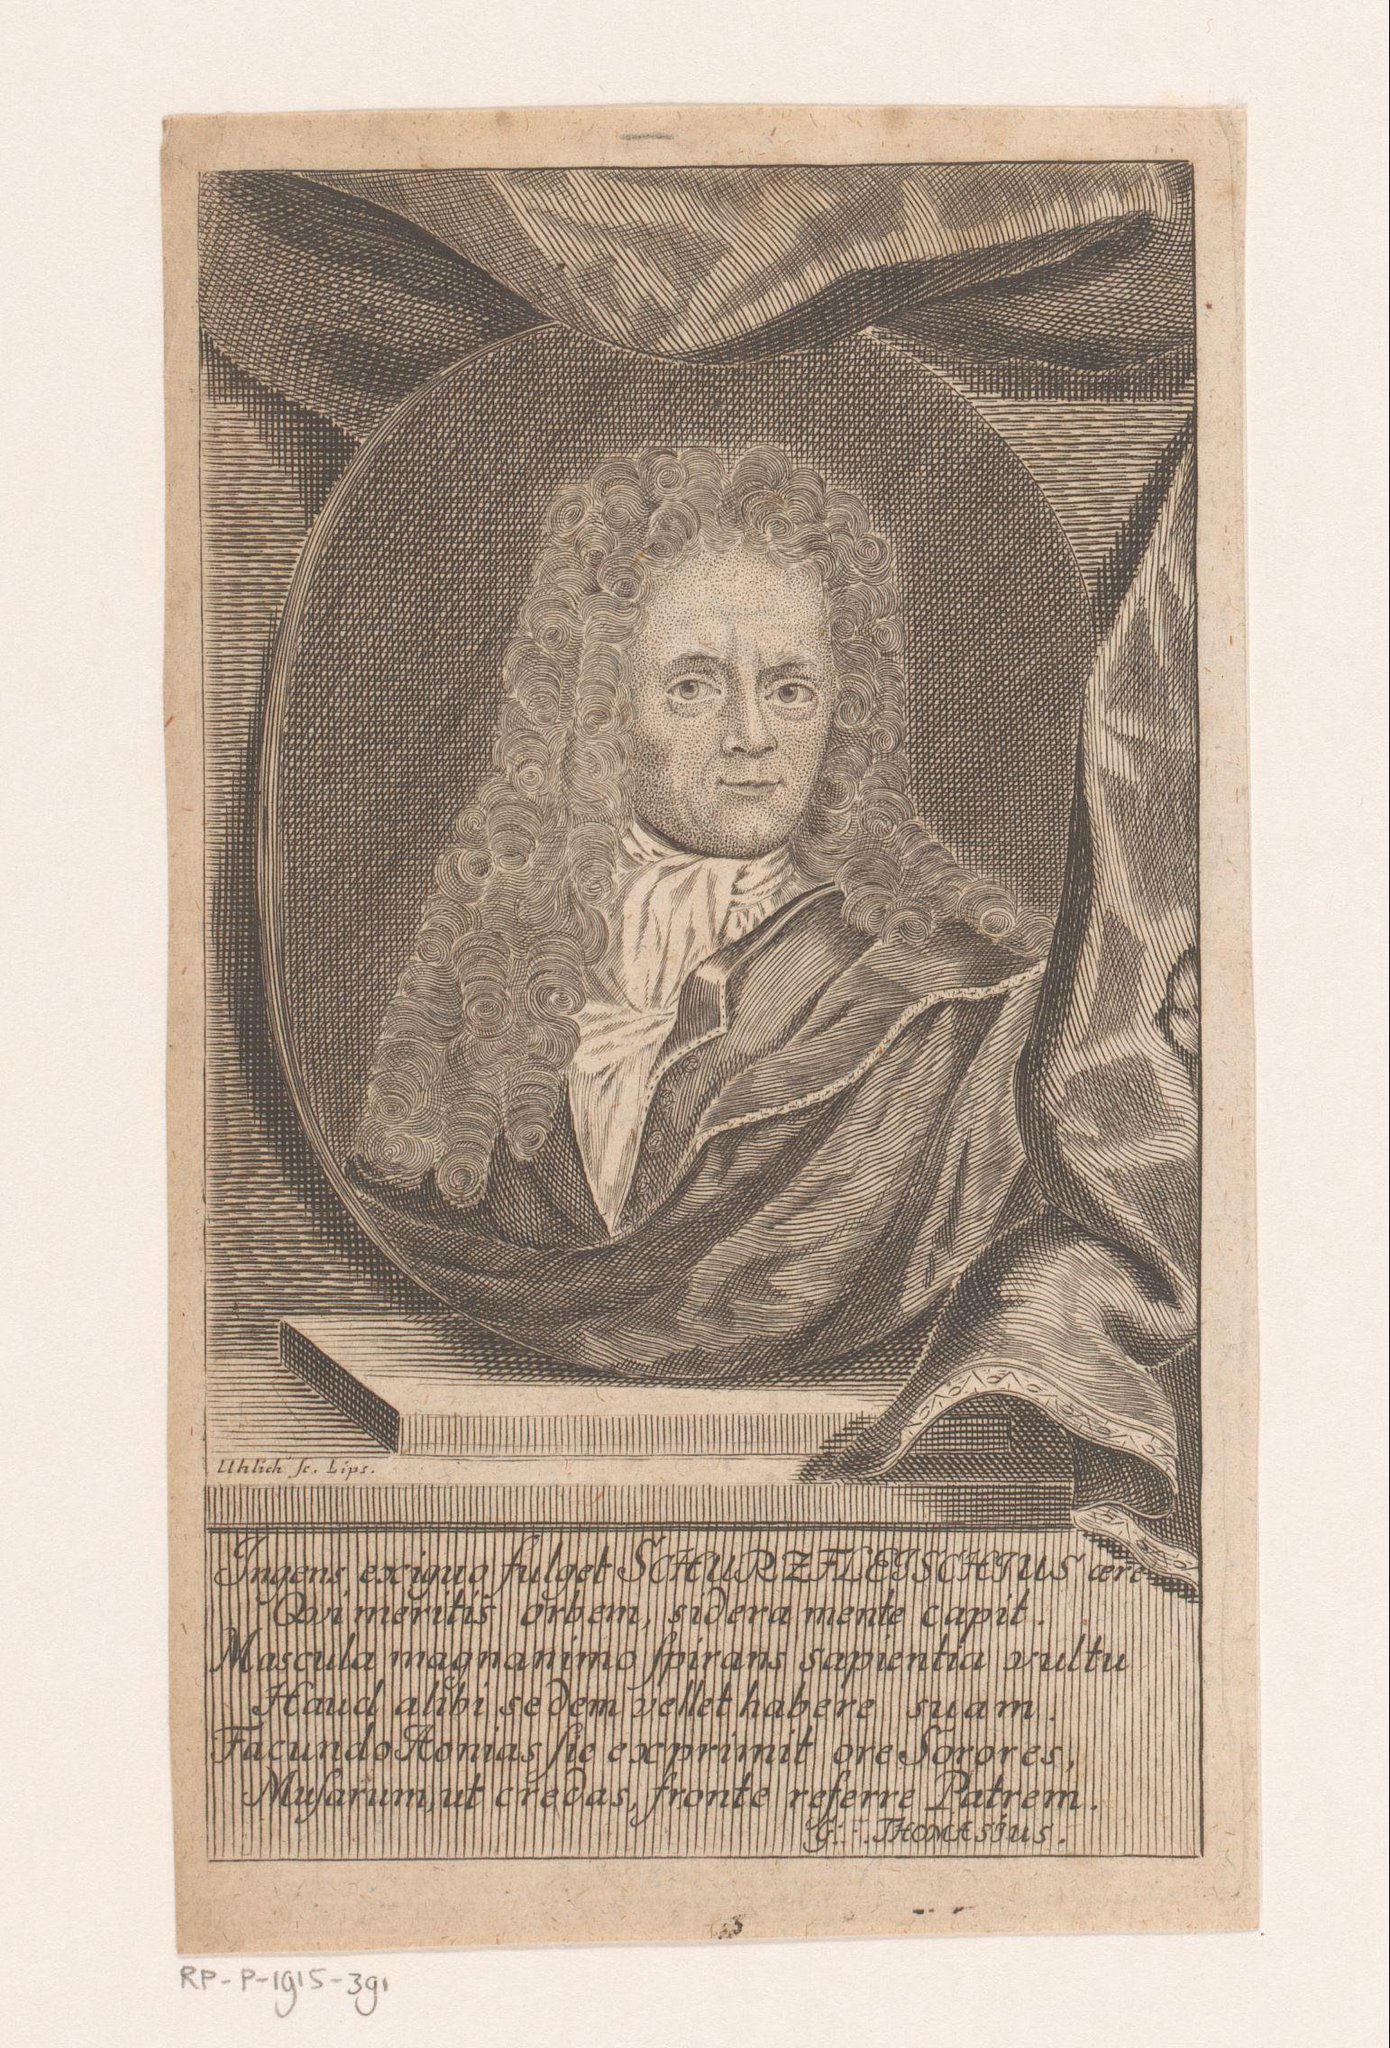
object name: print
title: Portret van Conrad Samuel Schurtzfleisch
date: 1712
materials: paper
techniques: engraving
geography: leipzig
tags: historical persons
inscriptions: collector's mark: Lugt 2228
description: Prent gebruikt voor de publicatie: Schurzfleisch, Conrad Samuel. Conradi Samuelis Schurtzfleischii Epistolae selectiores, nunc sine lacunis, cum Memoria auctoris editae ec promulgatae. Wittenberg: Gottfried Zimmermann, 1712.